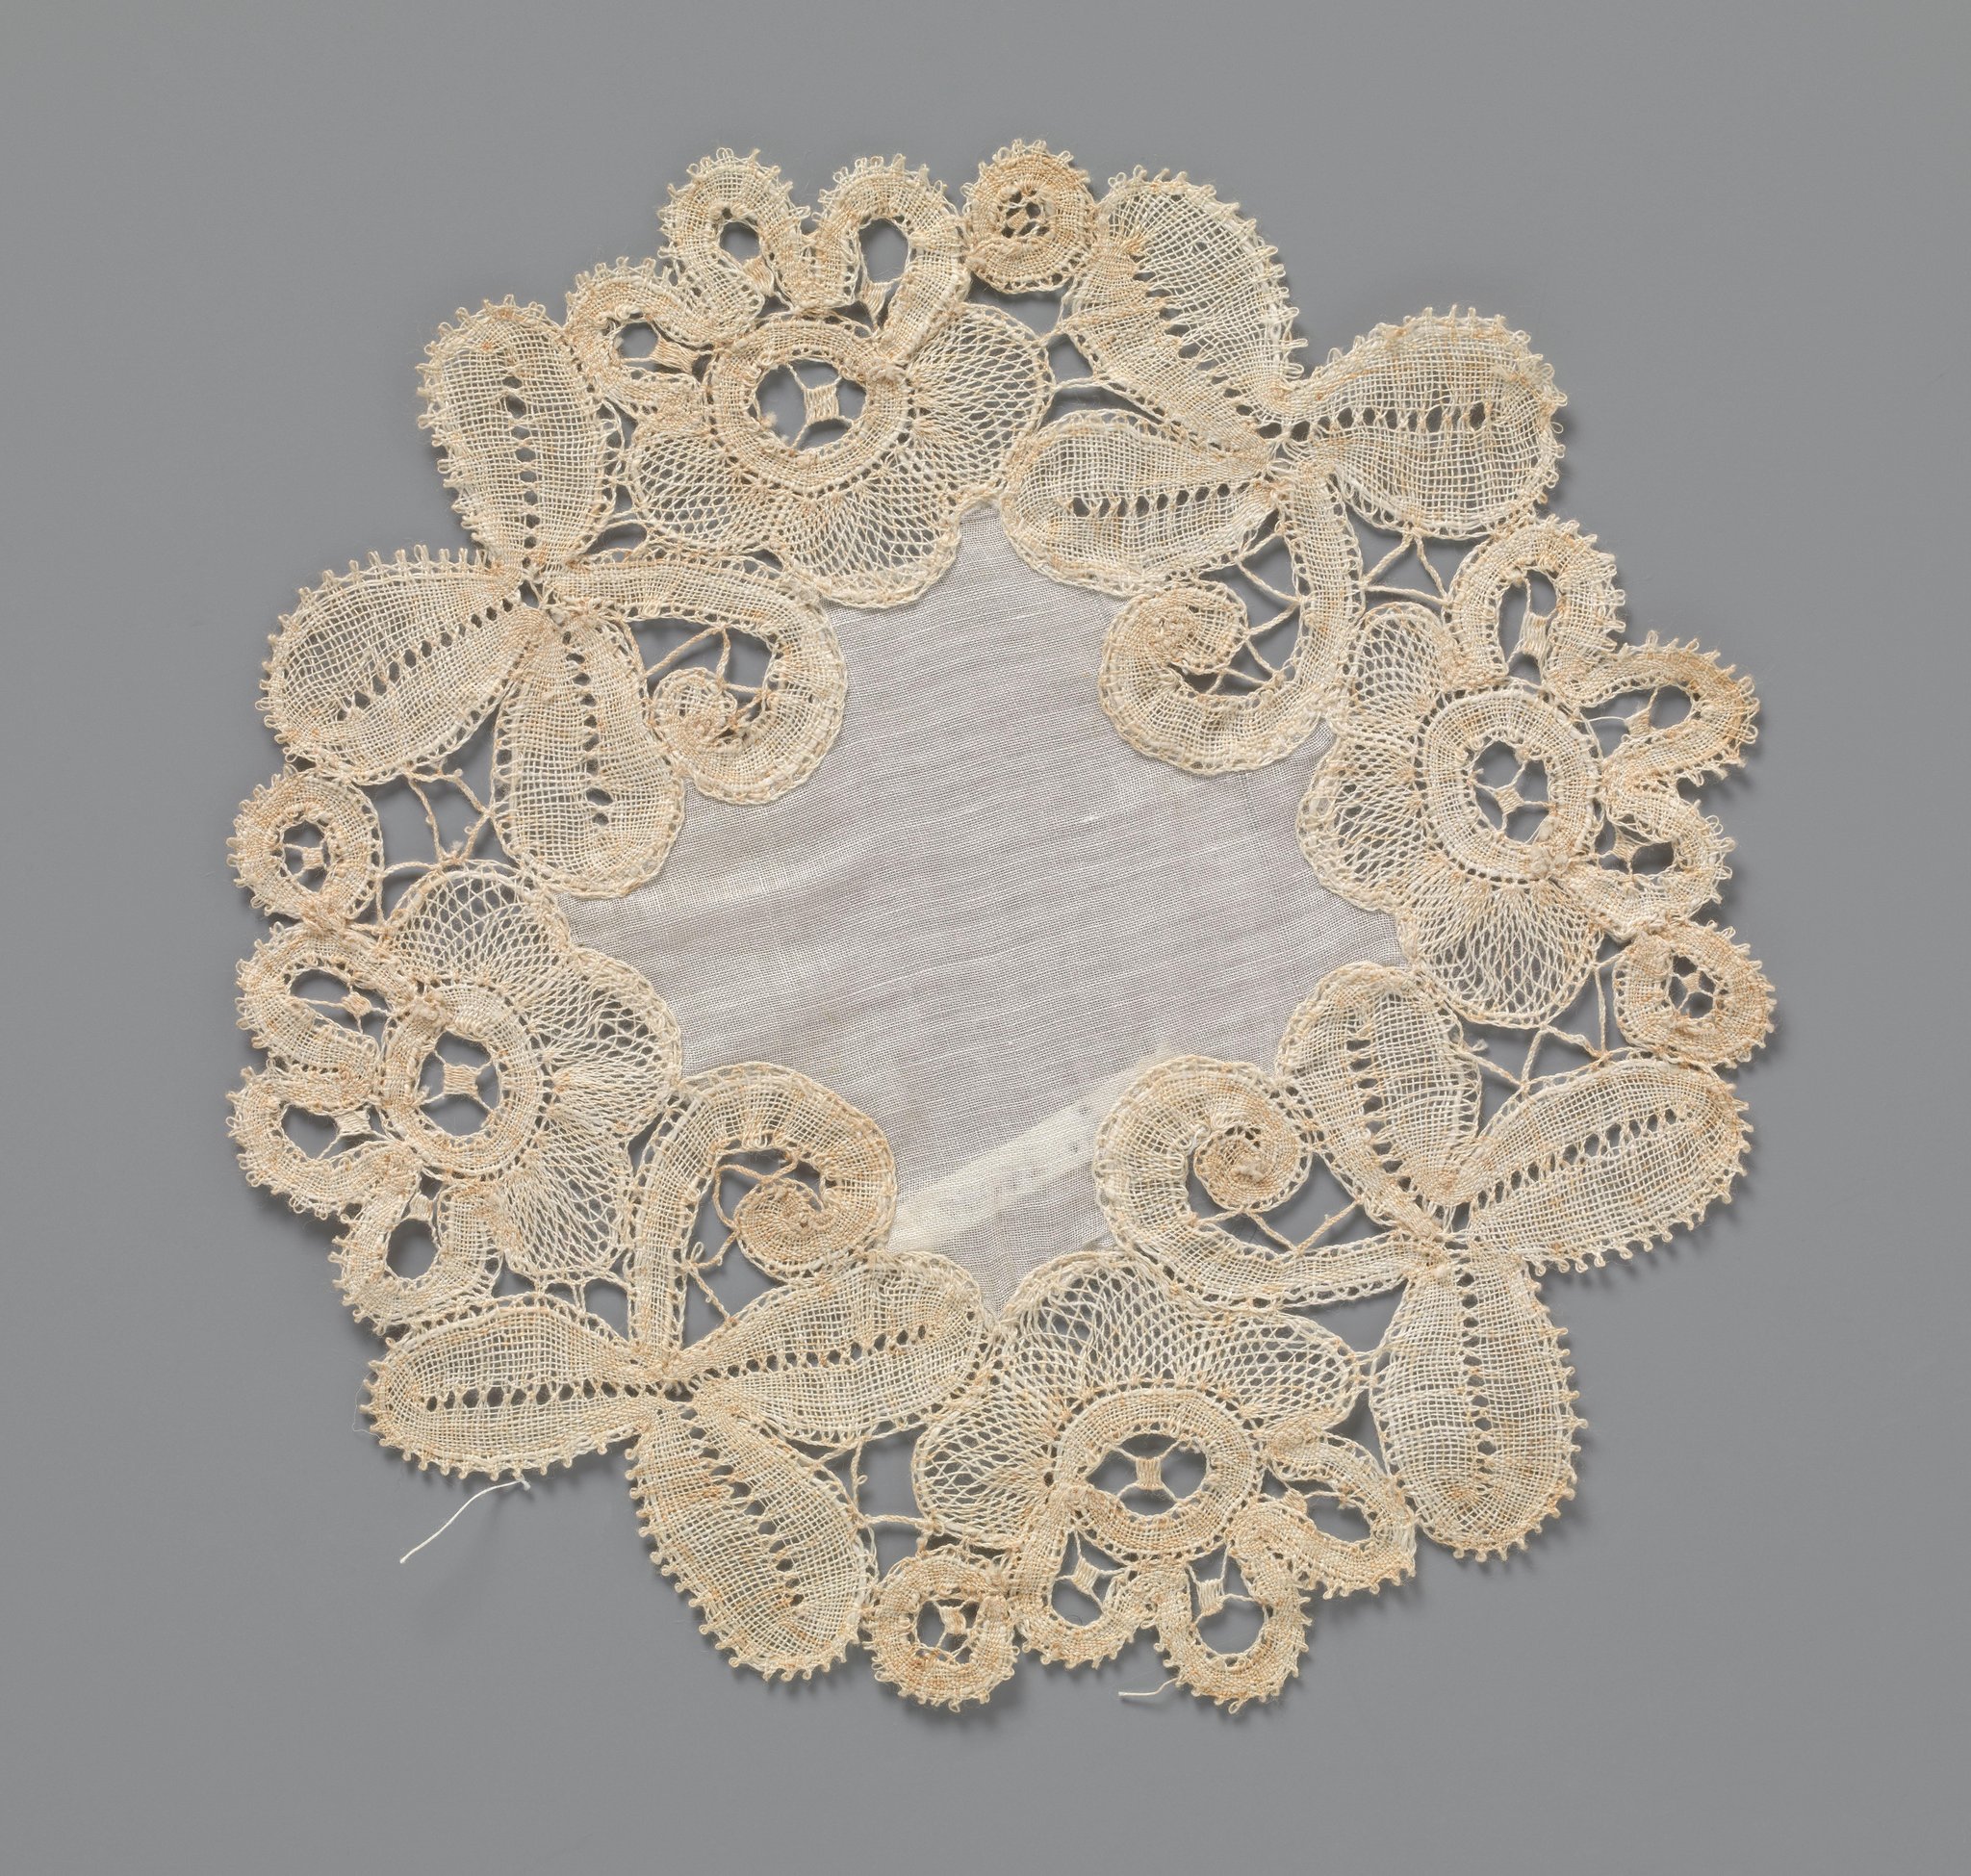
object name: kleed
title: Kleed of doily van kloskant met klavertje drie en rozetbloem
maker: Anonymous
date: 1875-1899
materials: linen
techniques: lace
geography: bruges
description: Kleed of doily van naturelkleurig kloskant: Brugs bloemwerk. Rond model met geschulpt vierkant middenstuk van batist. Het zich herhalende patroon bestaat afwisselend uit een klavertje drie en een rozetbloem. Aan de buitenrand staat tussen het blad en de bloem steeds een cirkeltje. De motieven zijn geklost in netslag en linnenslag, met opengewerkte randjes en uitsparingen als bladnerven. De motieven zijn geaccentueerd door contourdraden. In de bloemen zijn blokjes gemaakt in vormslag. Tussen de motieven zijn enkele verbindingen gemaakt met gepicoteerde vlechtjes. De schulpenrand komt voort uit het patroon en is rondom afgewerkt met picots.